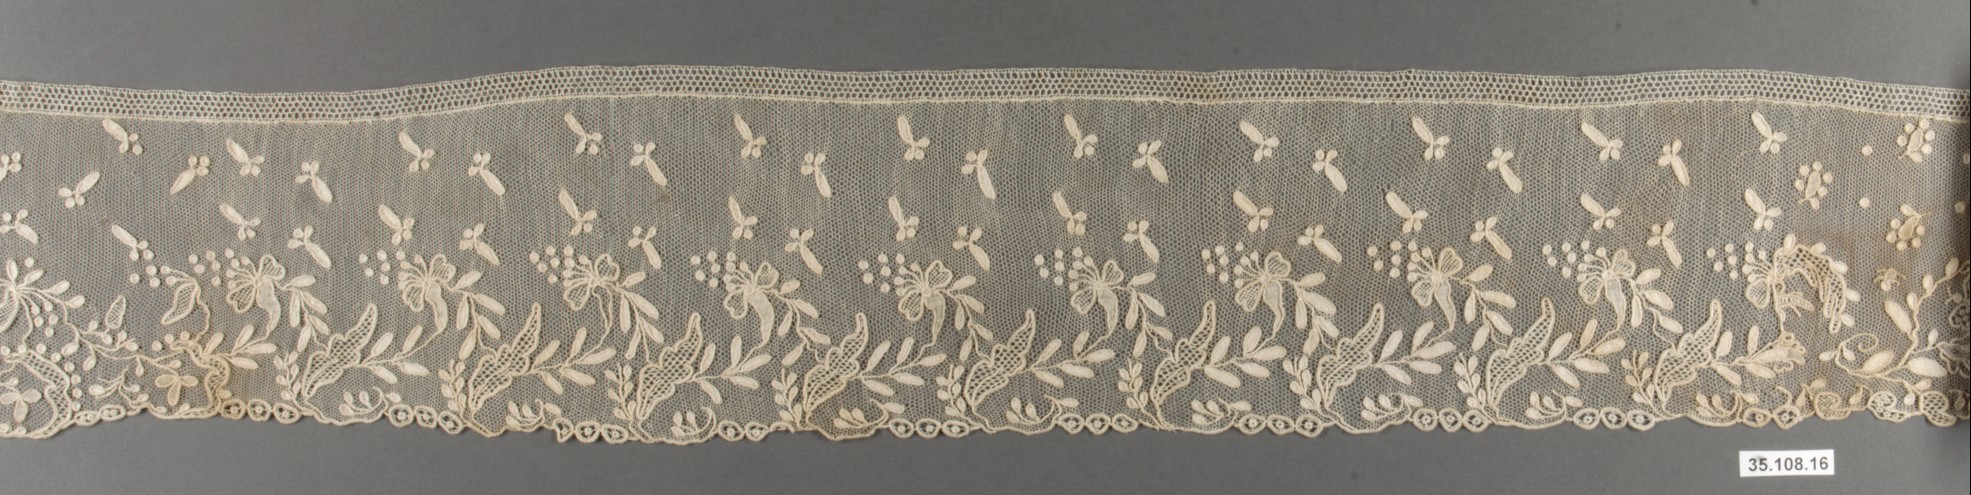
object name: border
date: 1767-1800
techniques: lace